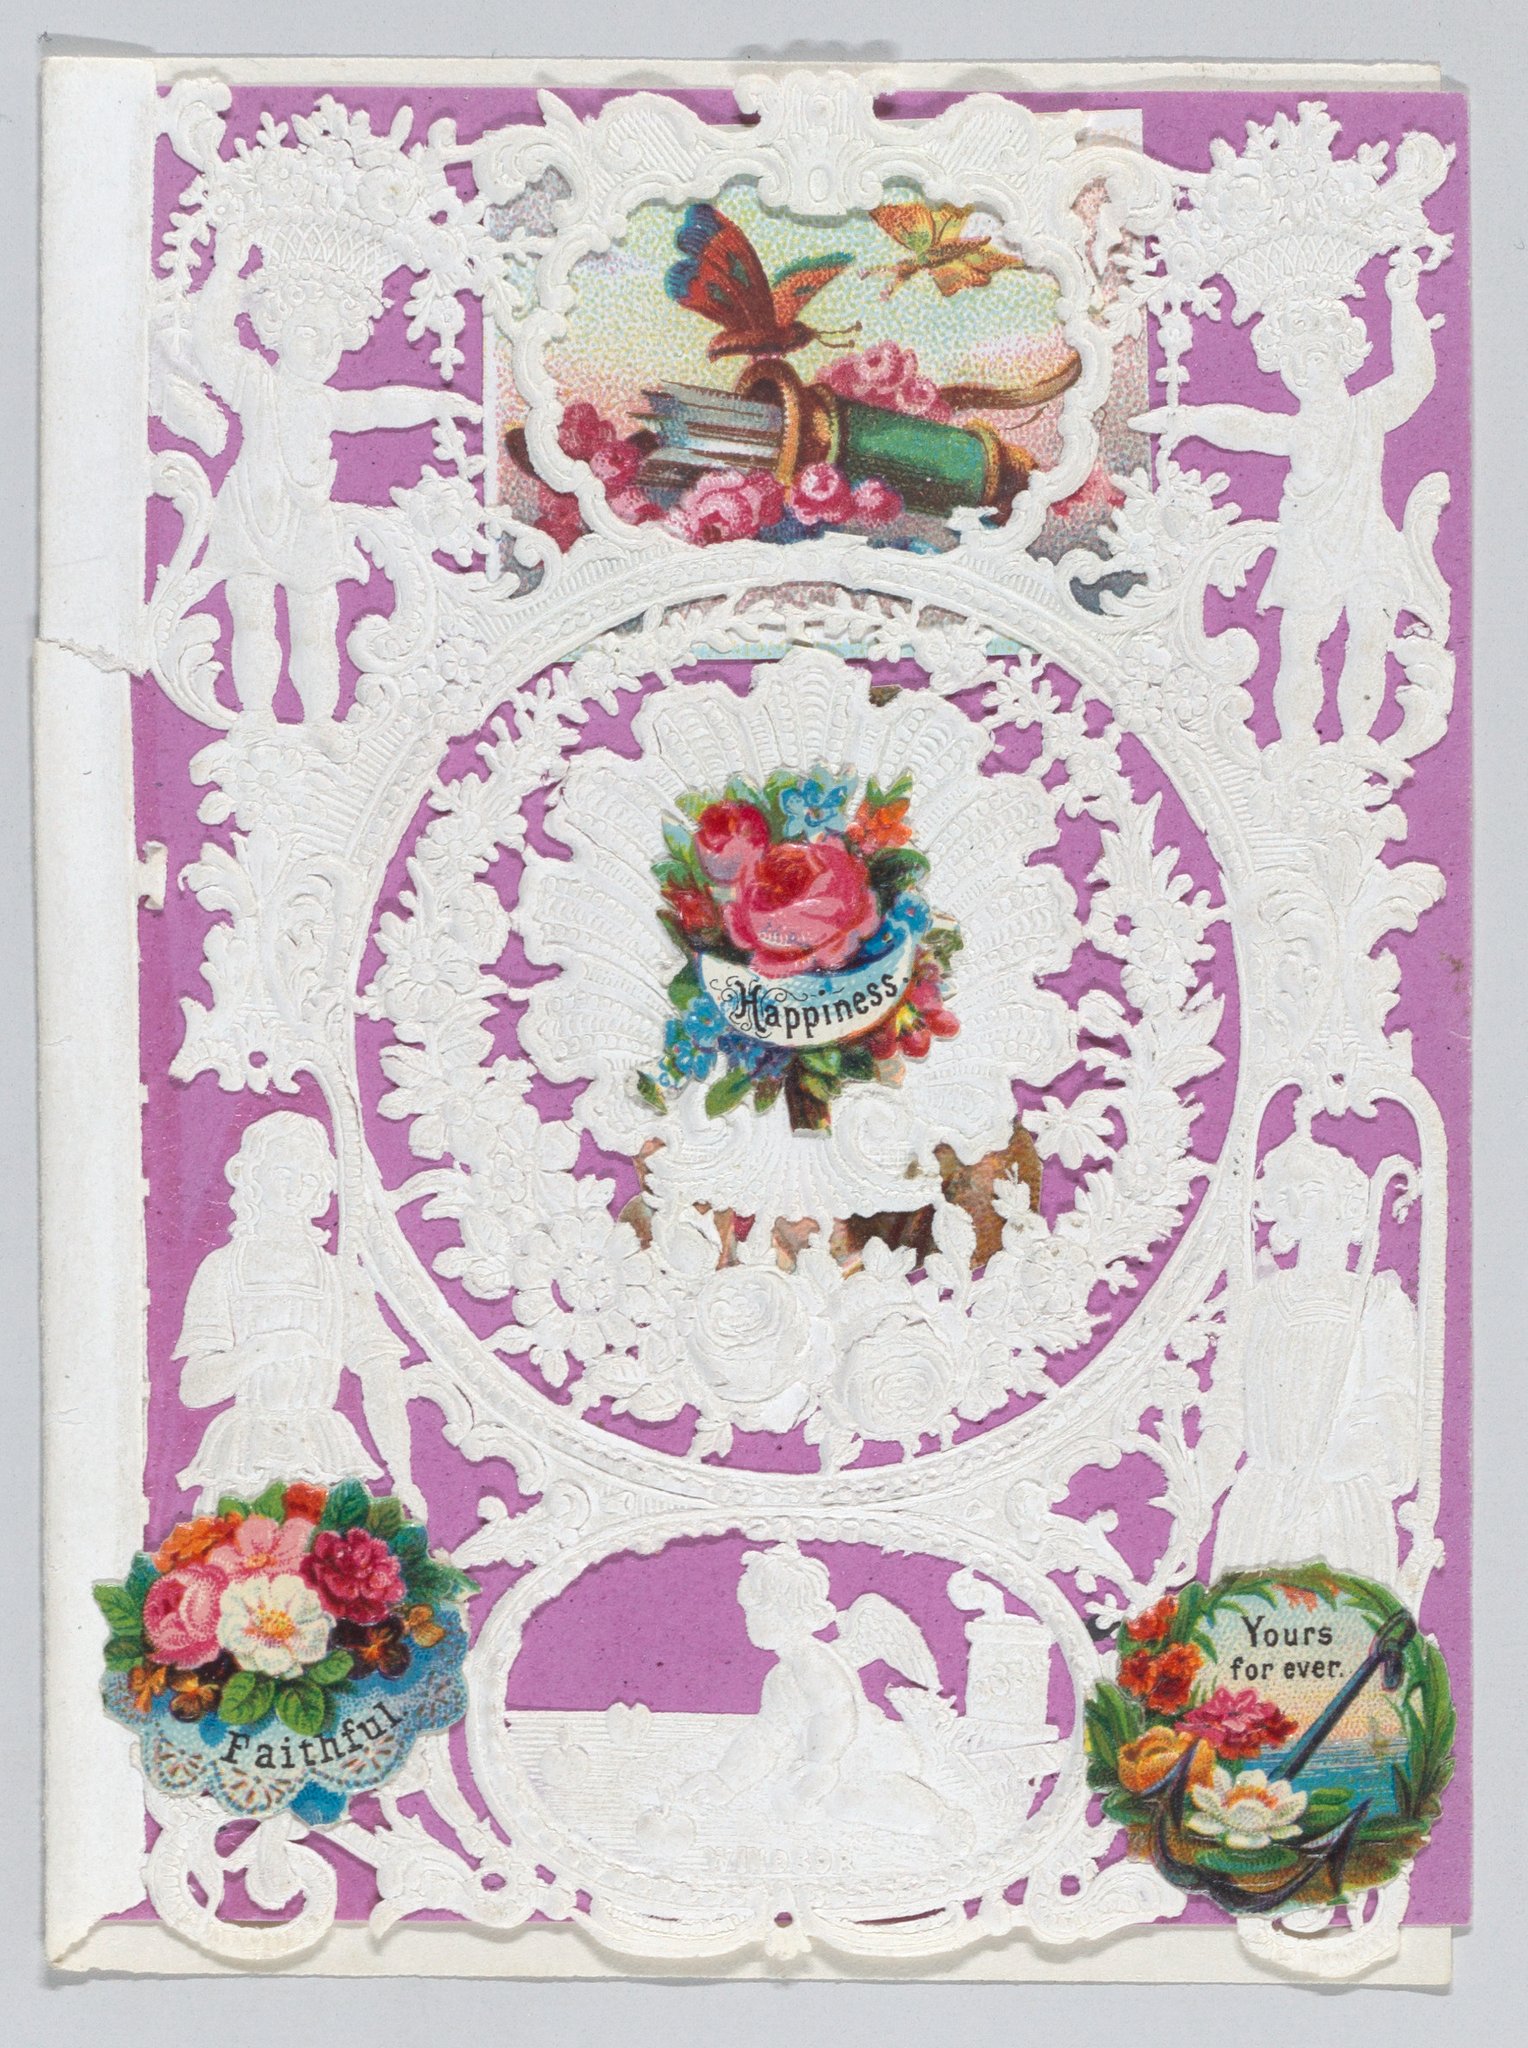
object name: valentine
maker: Anonymous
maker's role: artist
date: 1850-1870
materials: lace, paper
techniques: chromolithography, embossing, open work